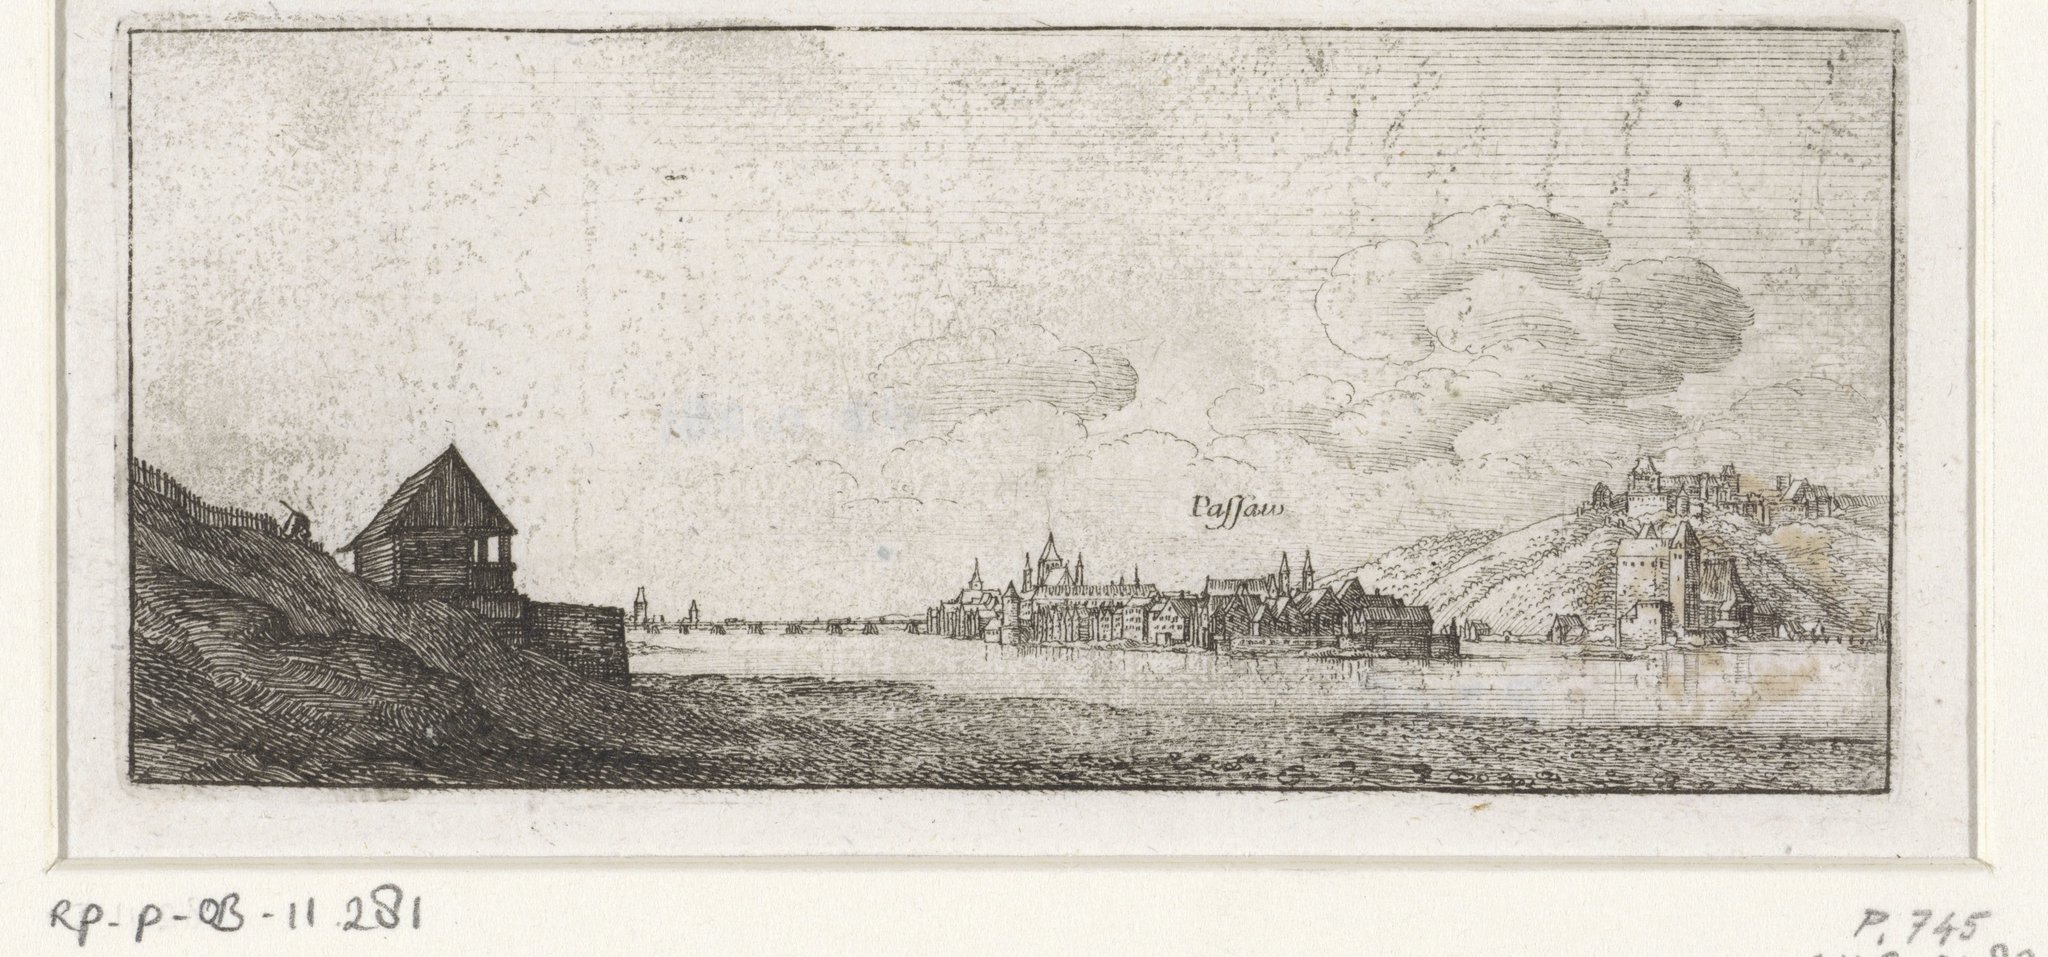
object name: print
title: Rivierlandschap met gezicht op Passau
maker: wenceslaus hollar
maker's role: draughtsman, print maker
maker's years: 1607-1677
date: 1625-1677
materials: paper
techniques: etching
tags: city-view, and landscape with man-made constructions, river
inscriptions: collector's mark: Lugt 240